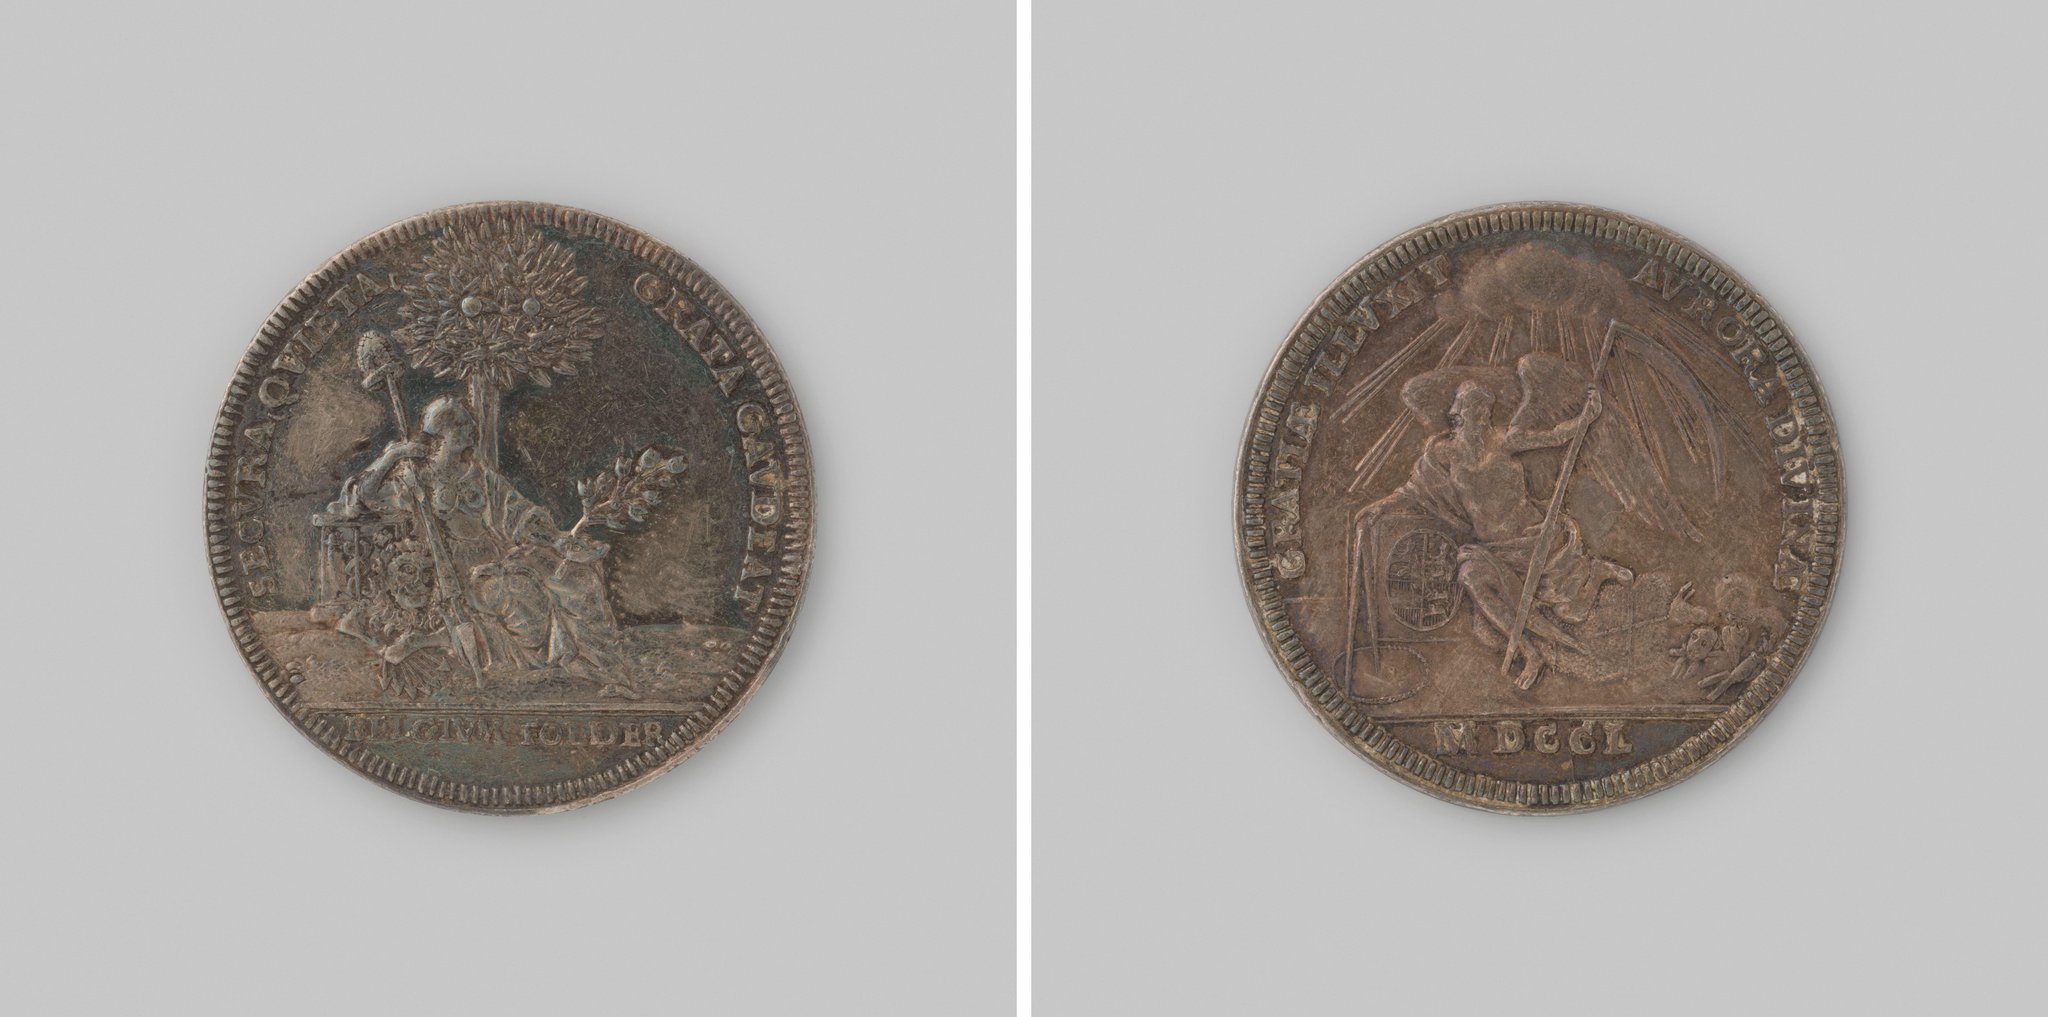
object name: history medal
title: Nieuwjaarspenning 1750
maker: johan george holtzhey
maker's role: mintmaster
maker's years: 1726-1808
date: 1750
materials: silver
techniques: striking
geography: amsterdam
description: Zilveren penning, op de voorzijde Nederland, met piek met vrijheidshoed en olijftak, zittend onder een oranjeboom tegen een altaar naast een leeuw met pijlenbundel, met omschrift en afsnedetekst, op de keerzijde de gevleugelde Tijd met zeis en passer, zittend op een baal koopwaar tegen het stadhouderlijk wapen en bedreigd door onheilssymbolen, trekt een jaarrond op de grond, met omschrift, in afsnede MDCCL.